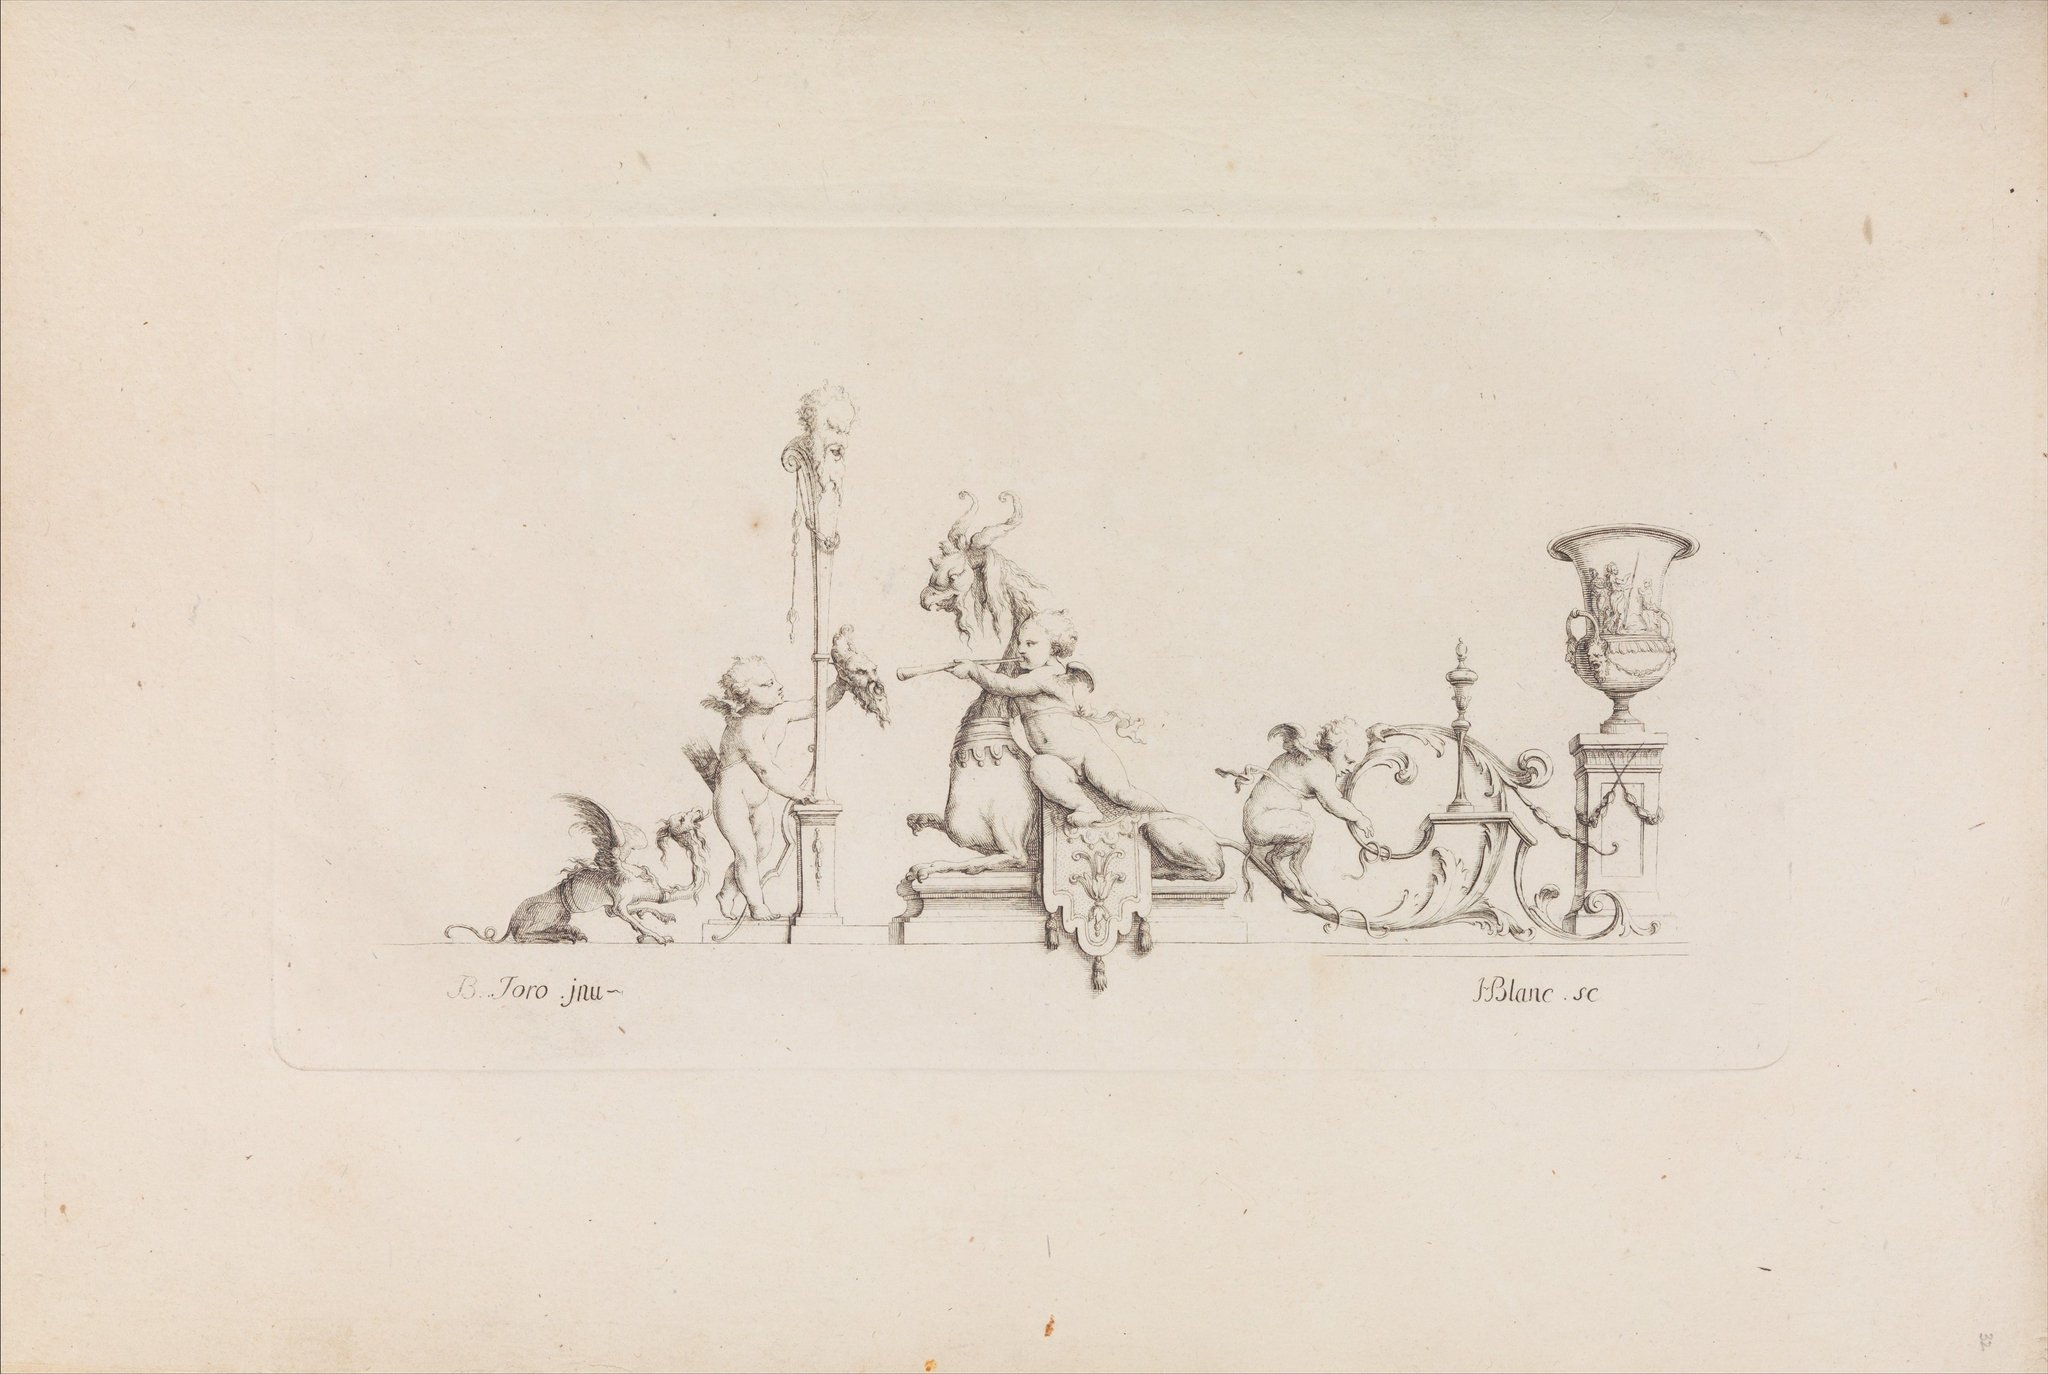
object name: album print ornament architecture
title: Desseins a Plusieurs Usages Inventés par M. B. Toro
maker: jean bernard toro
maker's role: designer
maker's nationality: french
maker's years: 1672-1731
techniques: etching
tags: grotesques,ornament,mythical creatures,putti